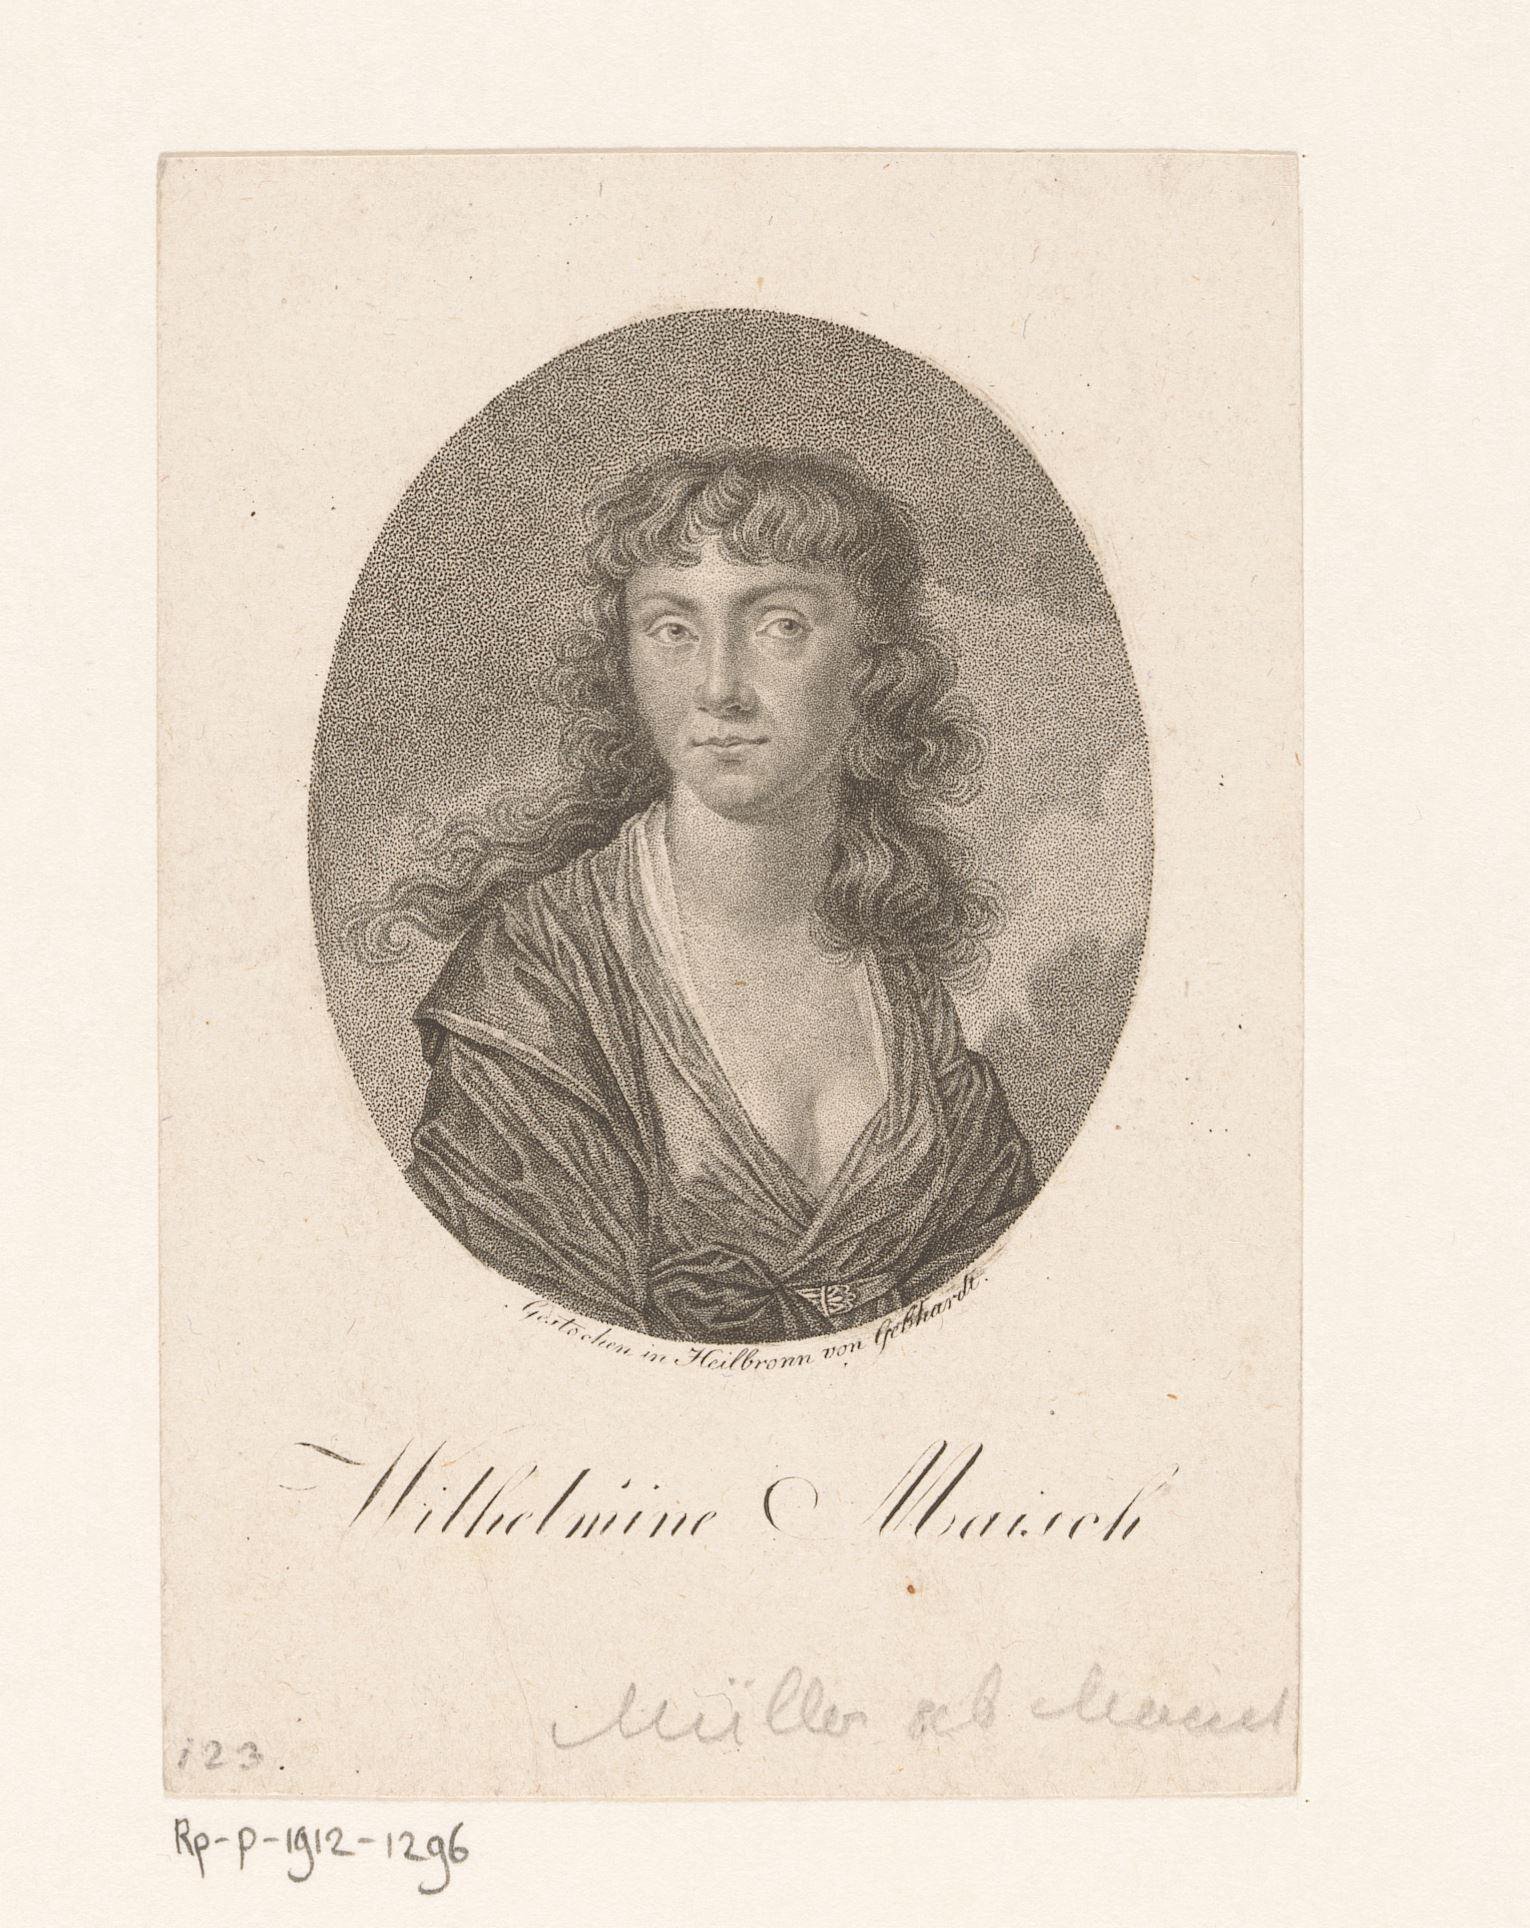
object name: print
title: Portret van Wilhelmine Augusta Müller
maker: franz xaver gebhard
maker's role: print maker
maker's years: 1775-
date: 1775-1807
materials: paper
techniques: stippling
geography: heilbronn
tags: historical persons - bb - woman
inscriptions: collector's mark: Lugt 2228